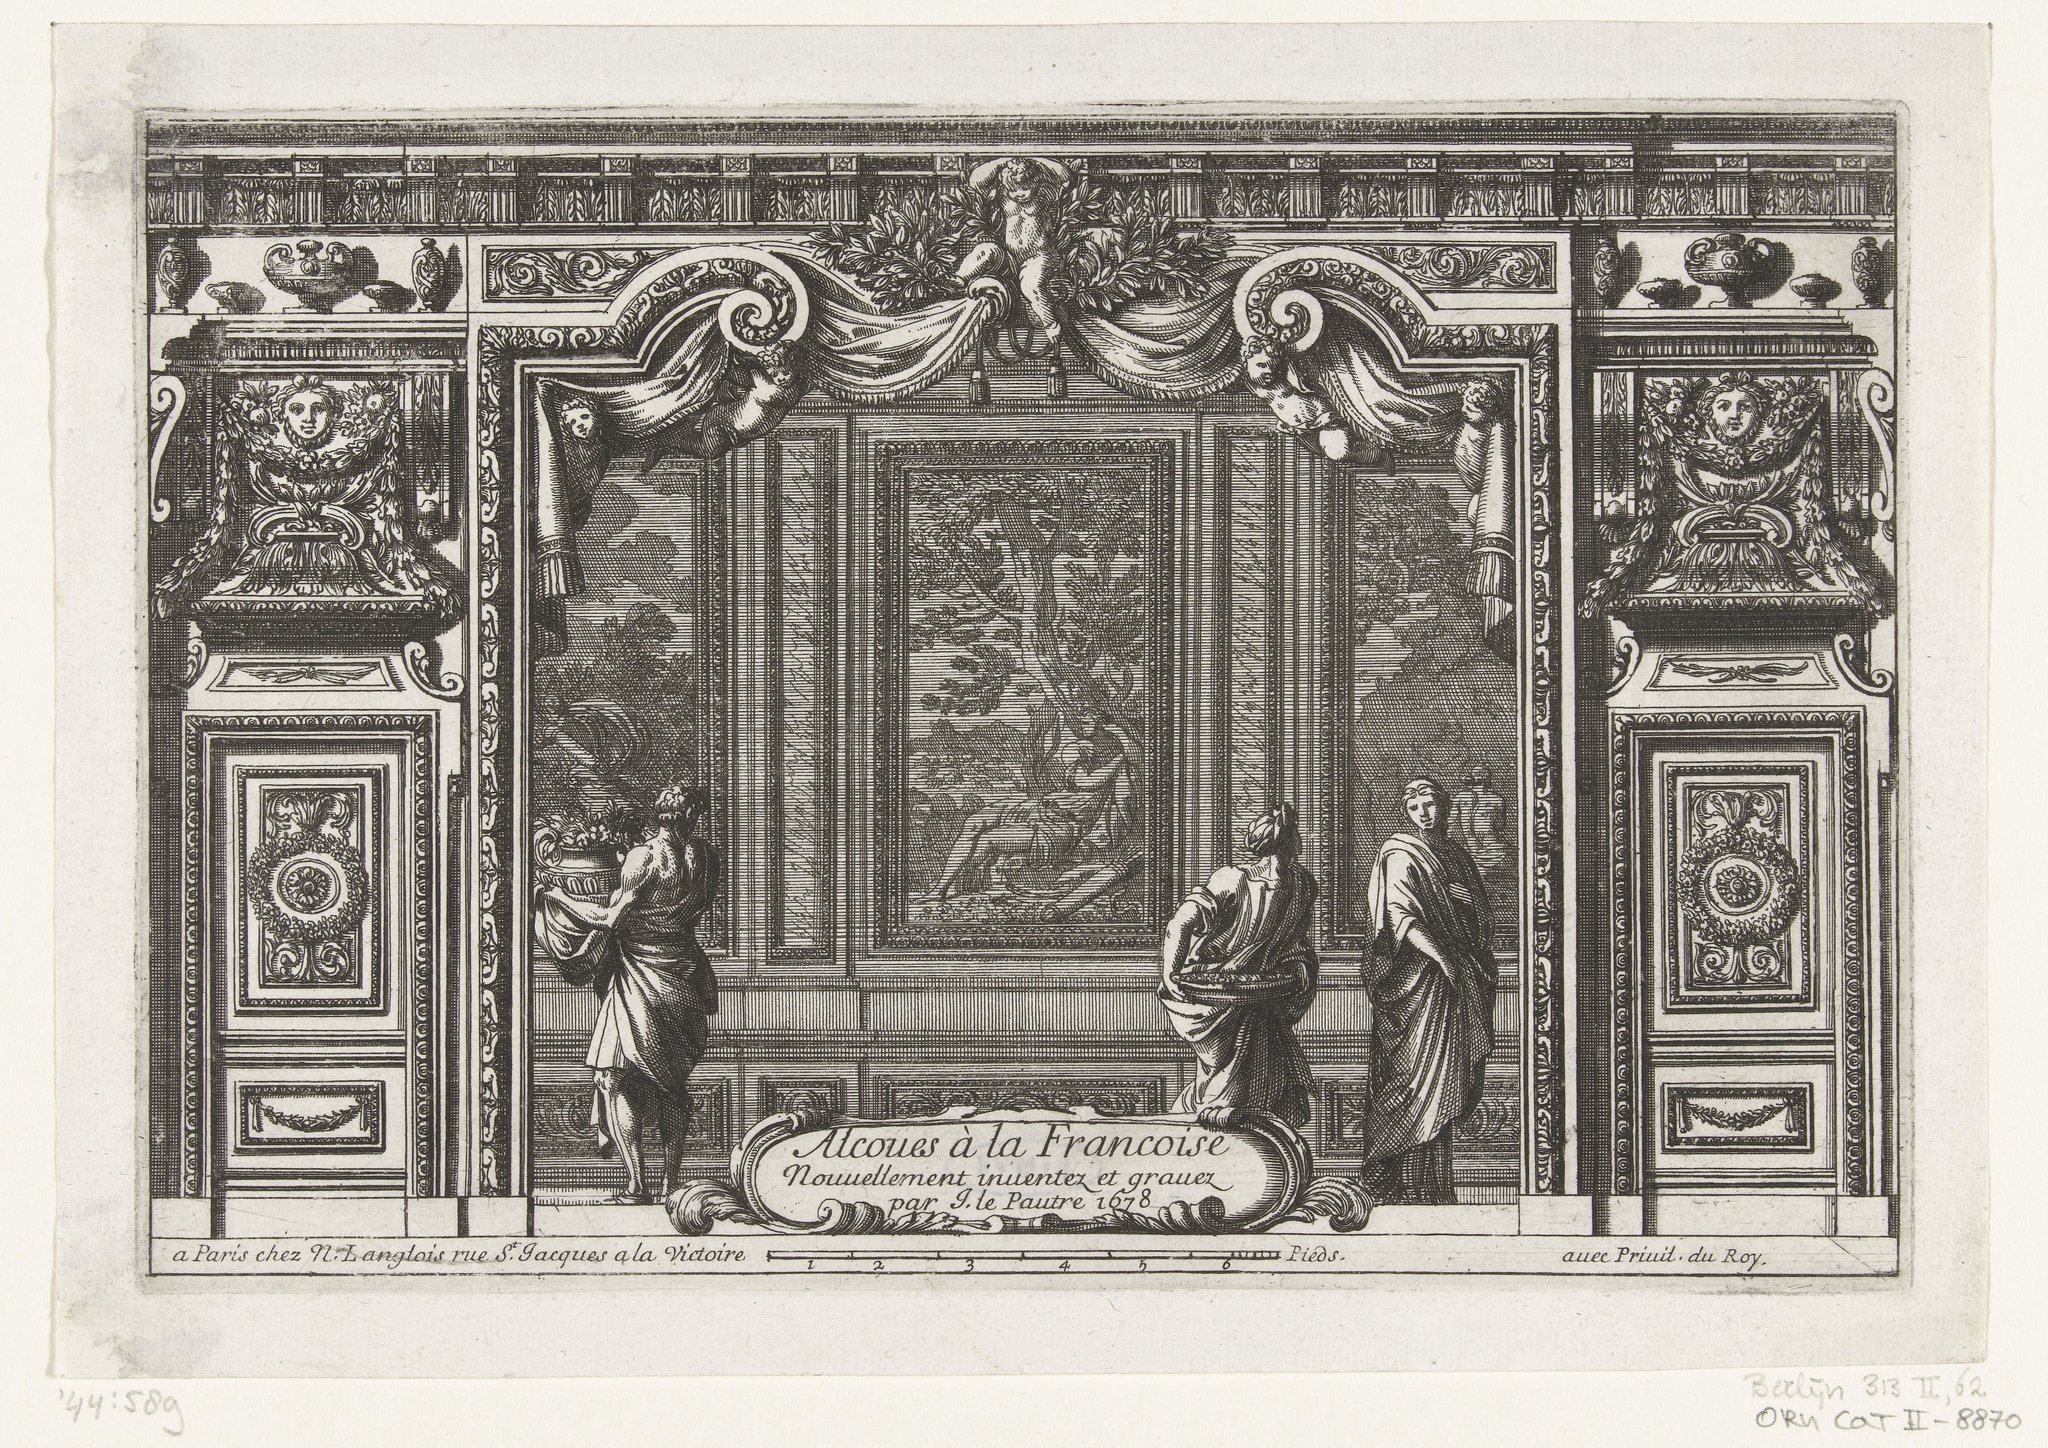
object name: titelblad, titelpagina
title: Titelblad: Alcoves à la Francoise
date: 1678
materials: paper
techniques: etching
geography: france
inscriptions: date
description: Alkoof, waarvan de achterste muur gedecoreerd is met schilderijen. Titelblad uit serie van 6 bladen. Derde afdruk.